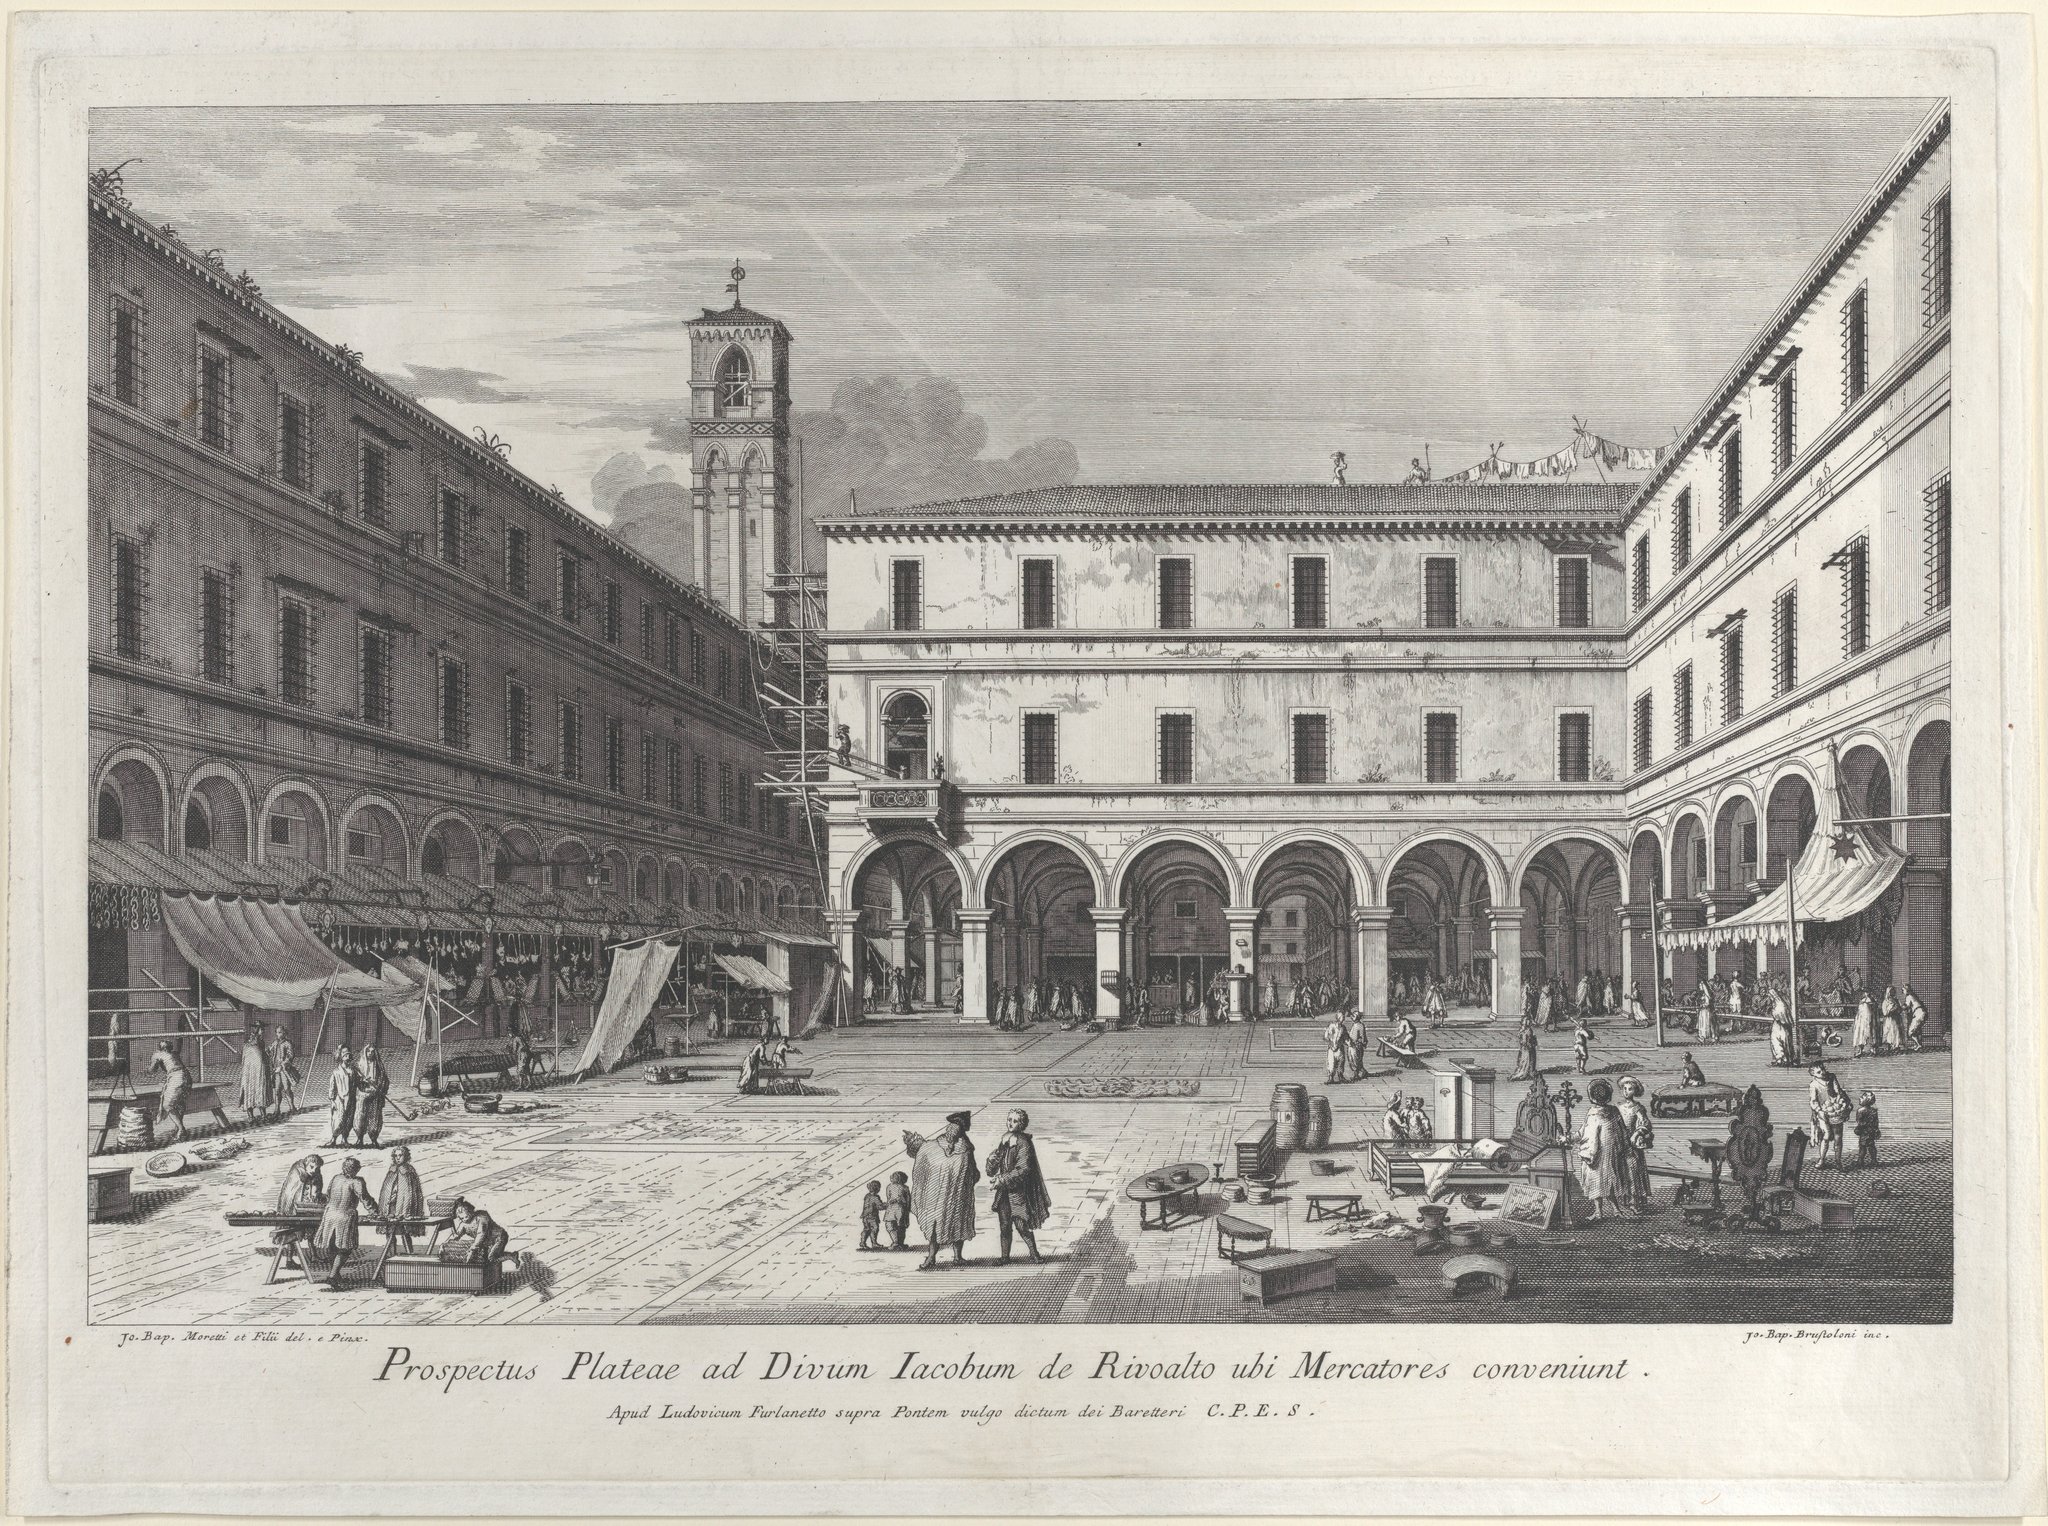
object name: print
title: View of the market square near the church of San Giacomo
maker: giovanni battista brustolon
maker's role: artist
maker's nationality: italian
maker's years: 1712-1796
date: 1763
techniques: etching